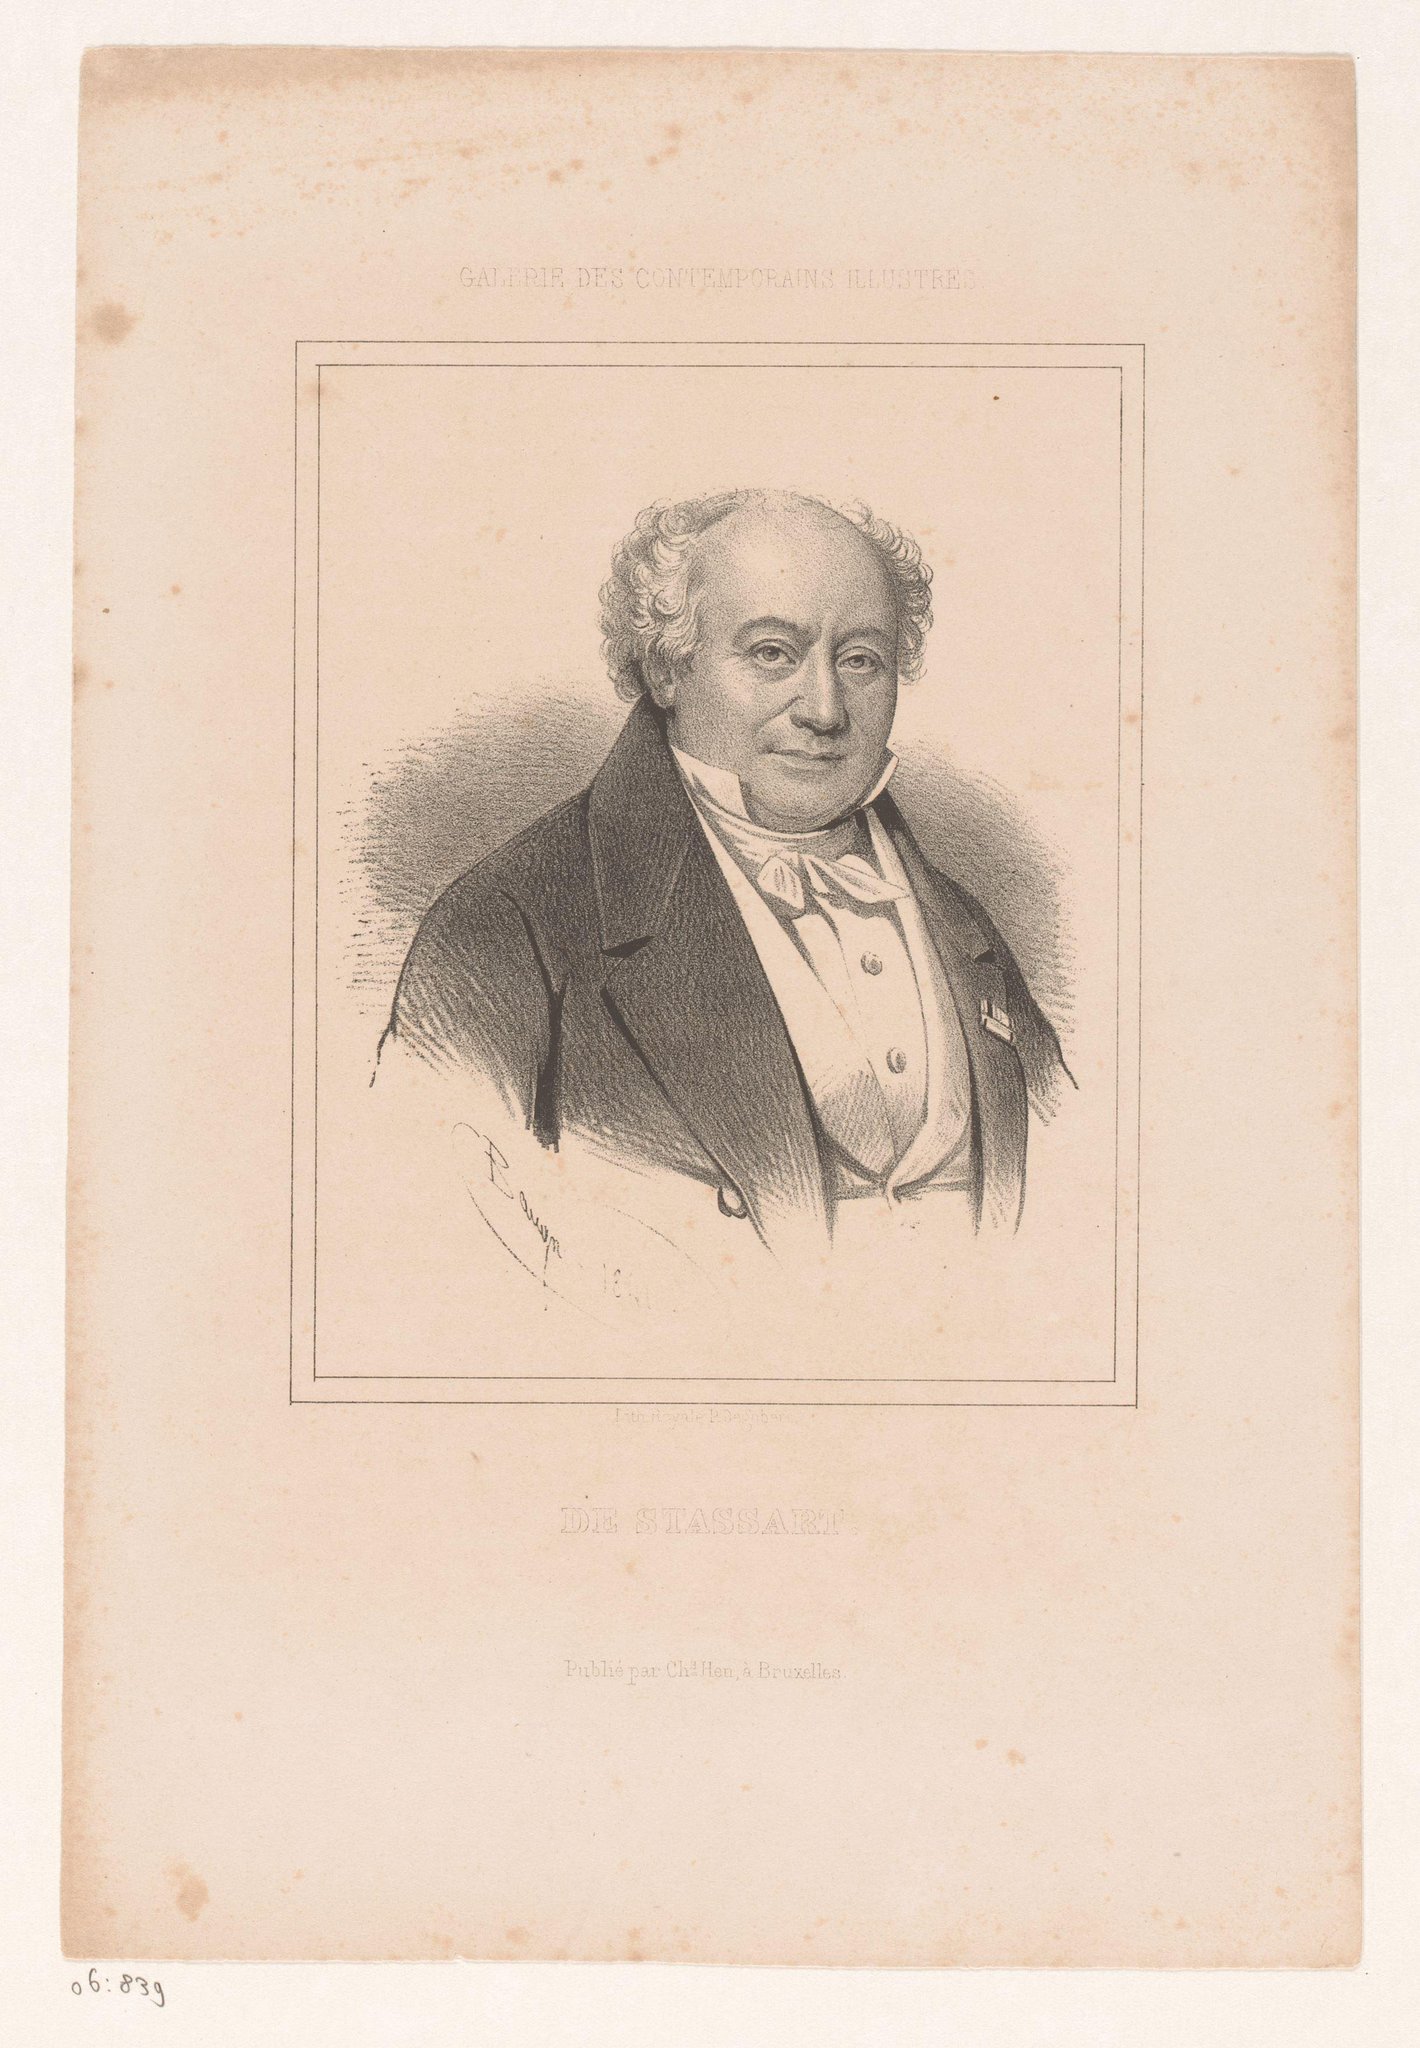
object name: print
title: Portret van Goswin Joseph Augustin de Stassart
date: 1841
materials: paper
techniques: lithograph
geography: brussels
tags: adult man, historical persons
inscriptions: collector's mark: Lugt 2228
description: Prent uit: Galerie des contemporains illustres. Brussel: Ch. Hen, 1841.